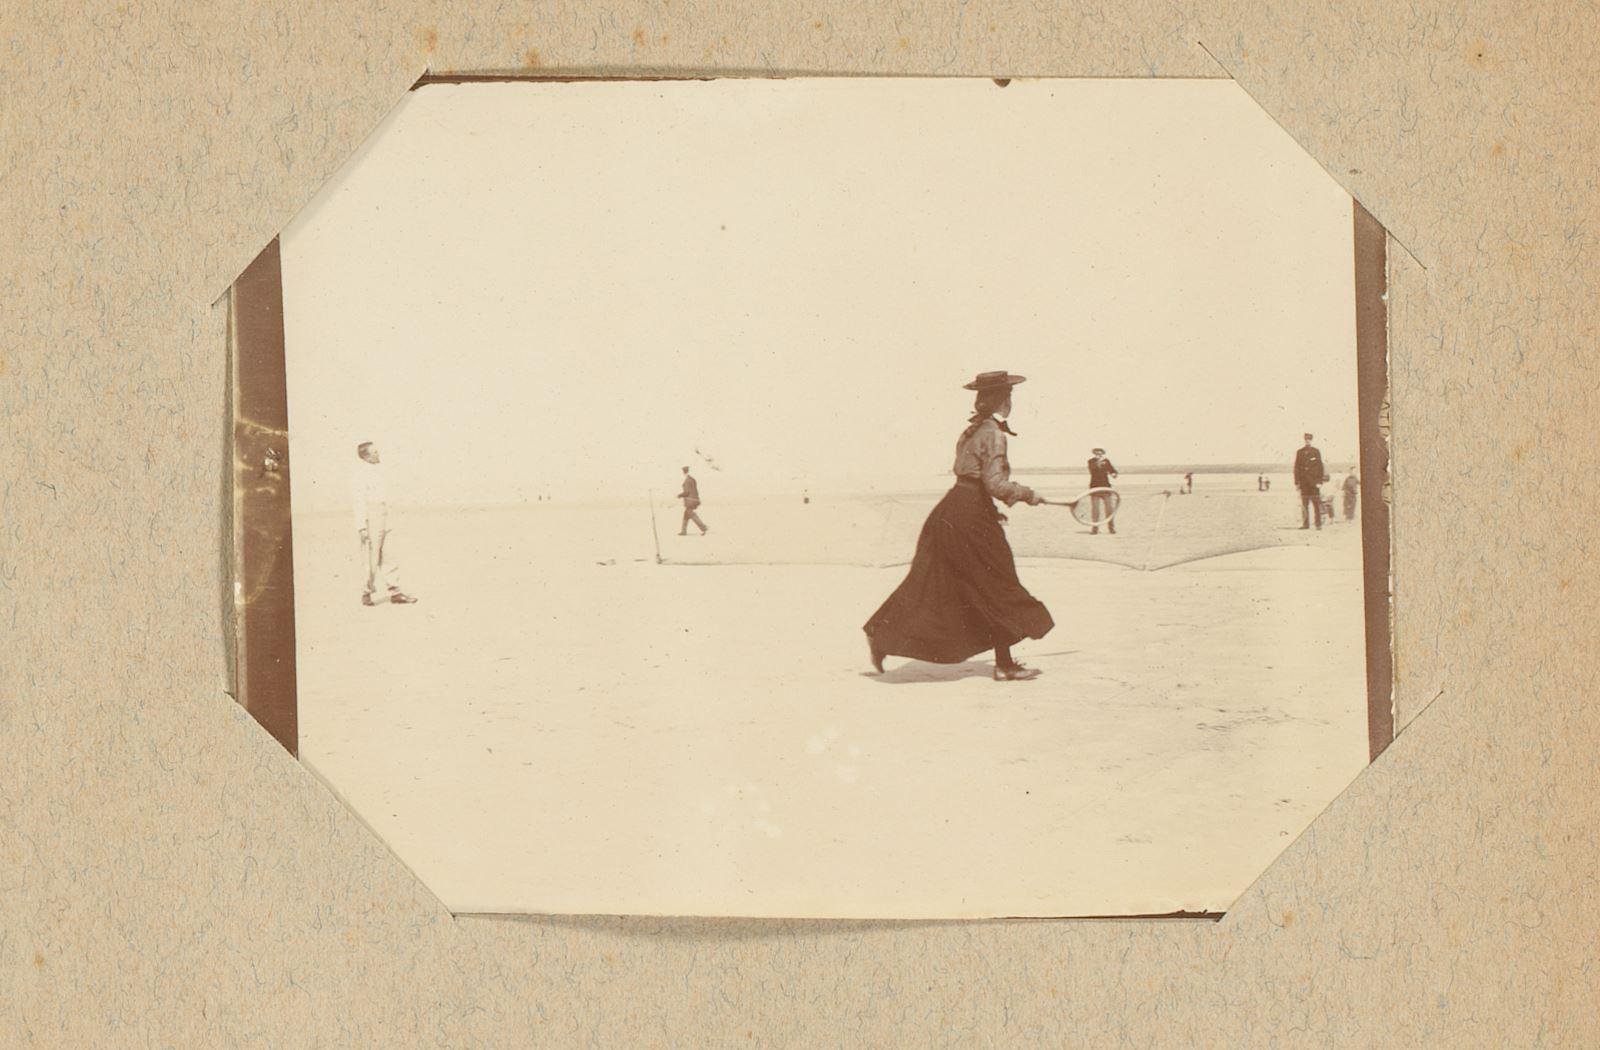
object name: album leaf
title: Vrouw tennist op het strand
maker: Anonymous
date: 1897-1900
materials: paper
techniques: gelatin silver print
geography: france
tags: beach (as place of recreation), tennis, lawn-tennis, france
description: Over de foto is een ander negatief afgedrukt van een voorstelling van bomen.